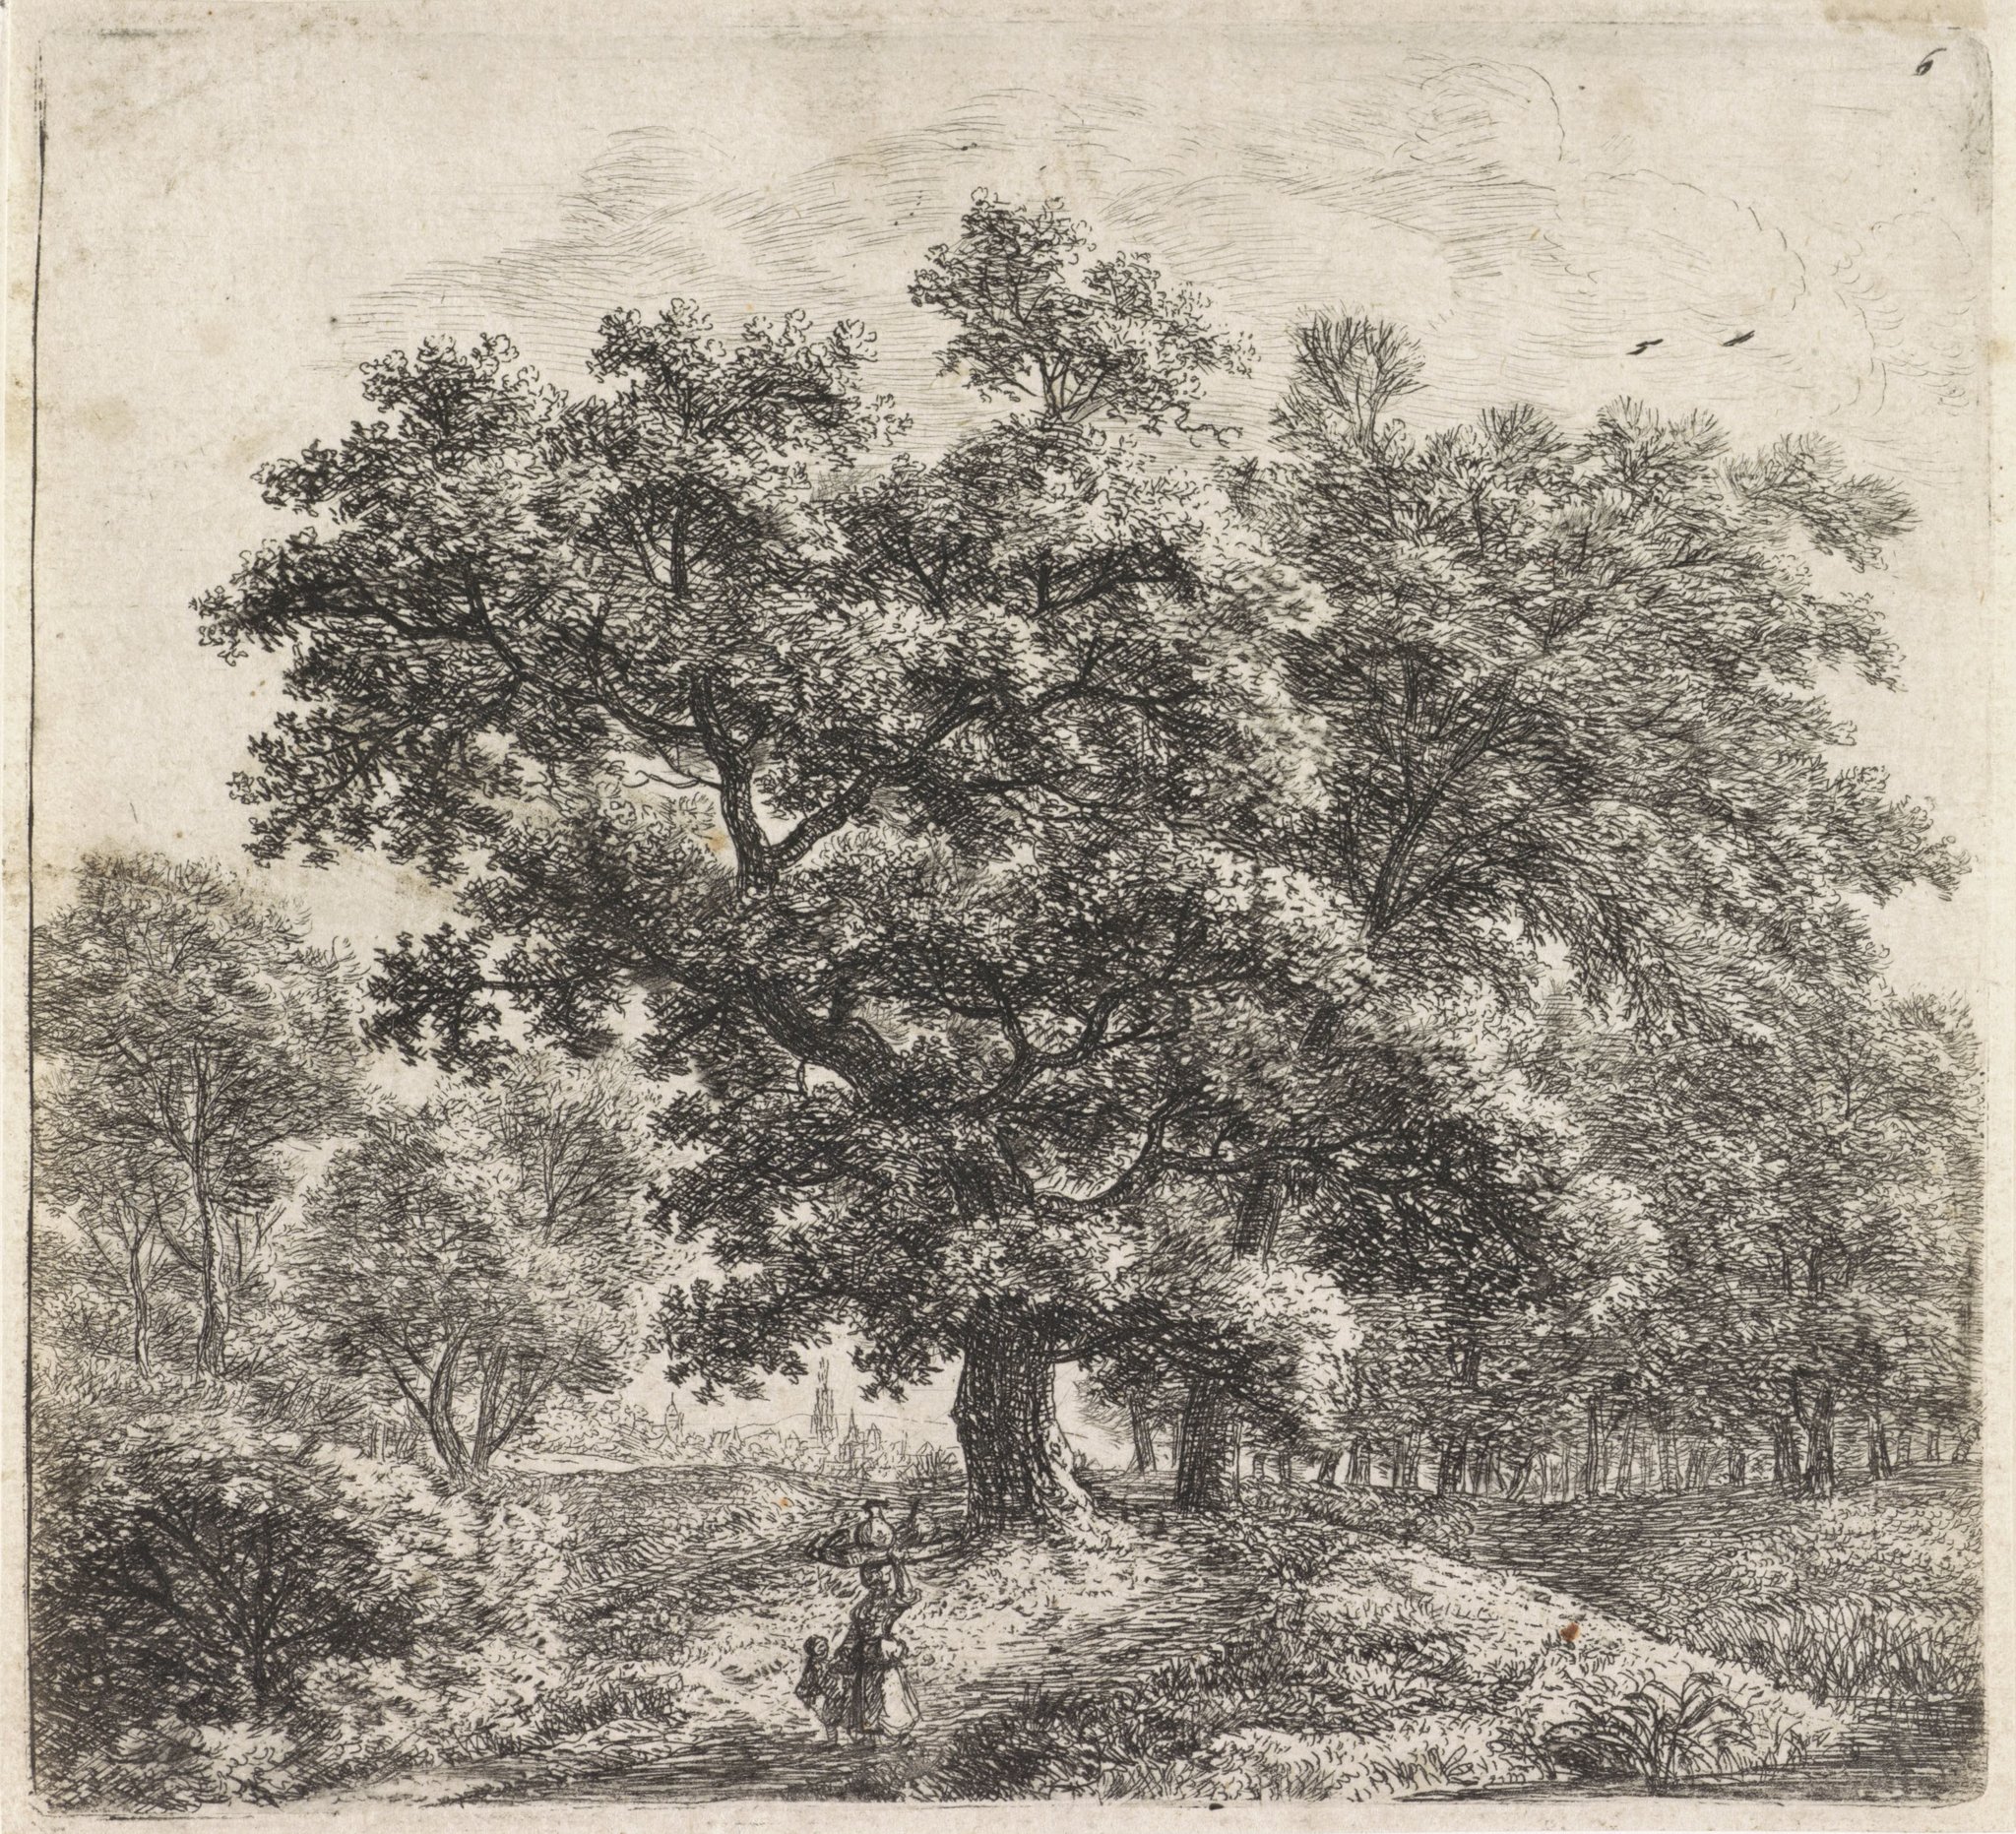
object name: print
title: Bosgezichten, serie B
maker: anthonie waterloo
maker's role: draughtsman, painter, print maker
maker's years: 1609-1690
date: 1630-1663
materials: paper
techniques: etching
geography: amsterdam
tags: child, village, forest, wood, milkmaid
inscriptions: collector's mark: Lugt 567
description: Op een bospad loopt een kind naast een jonge vrouw. De vrouw draagt een emmer in haar hand en twee kruiken op haar hoofd. In de verte ligt een dorp of stad.